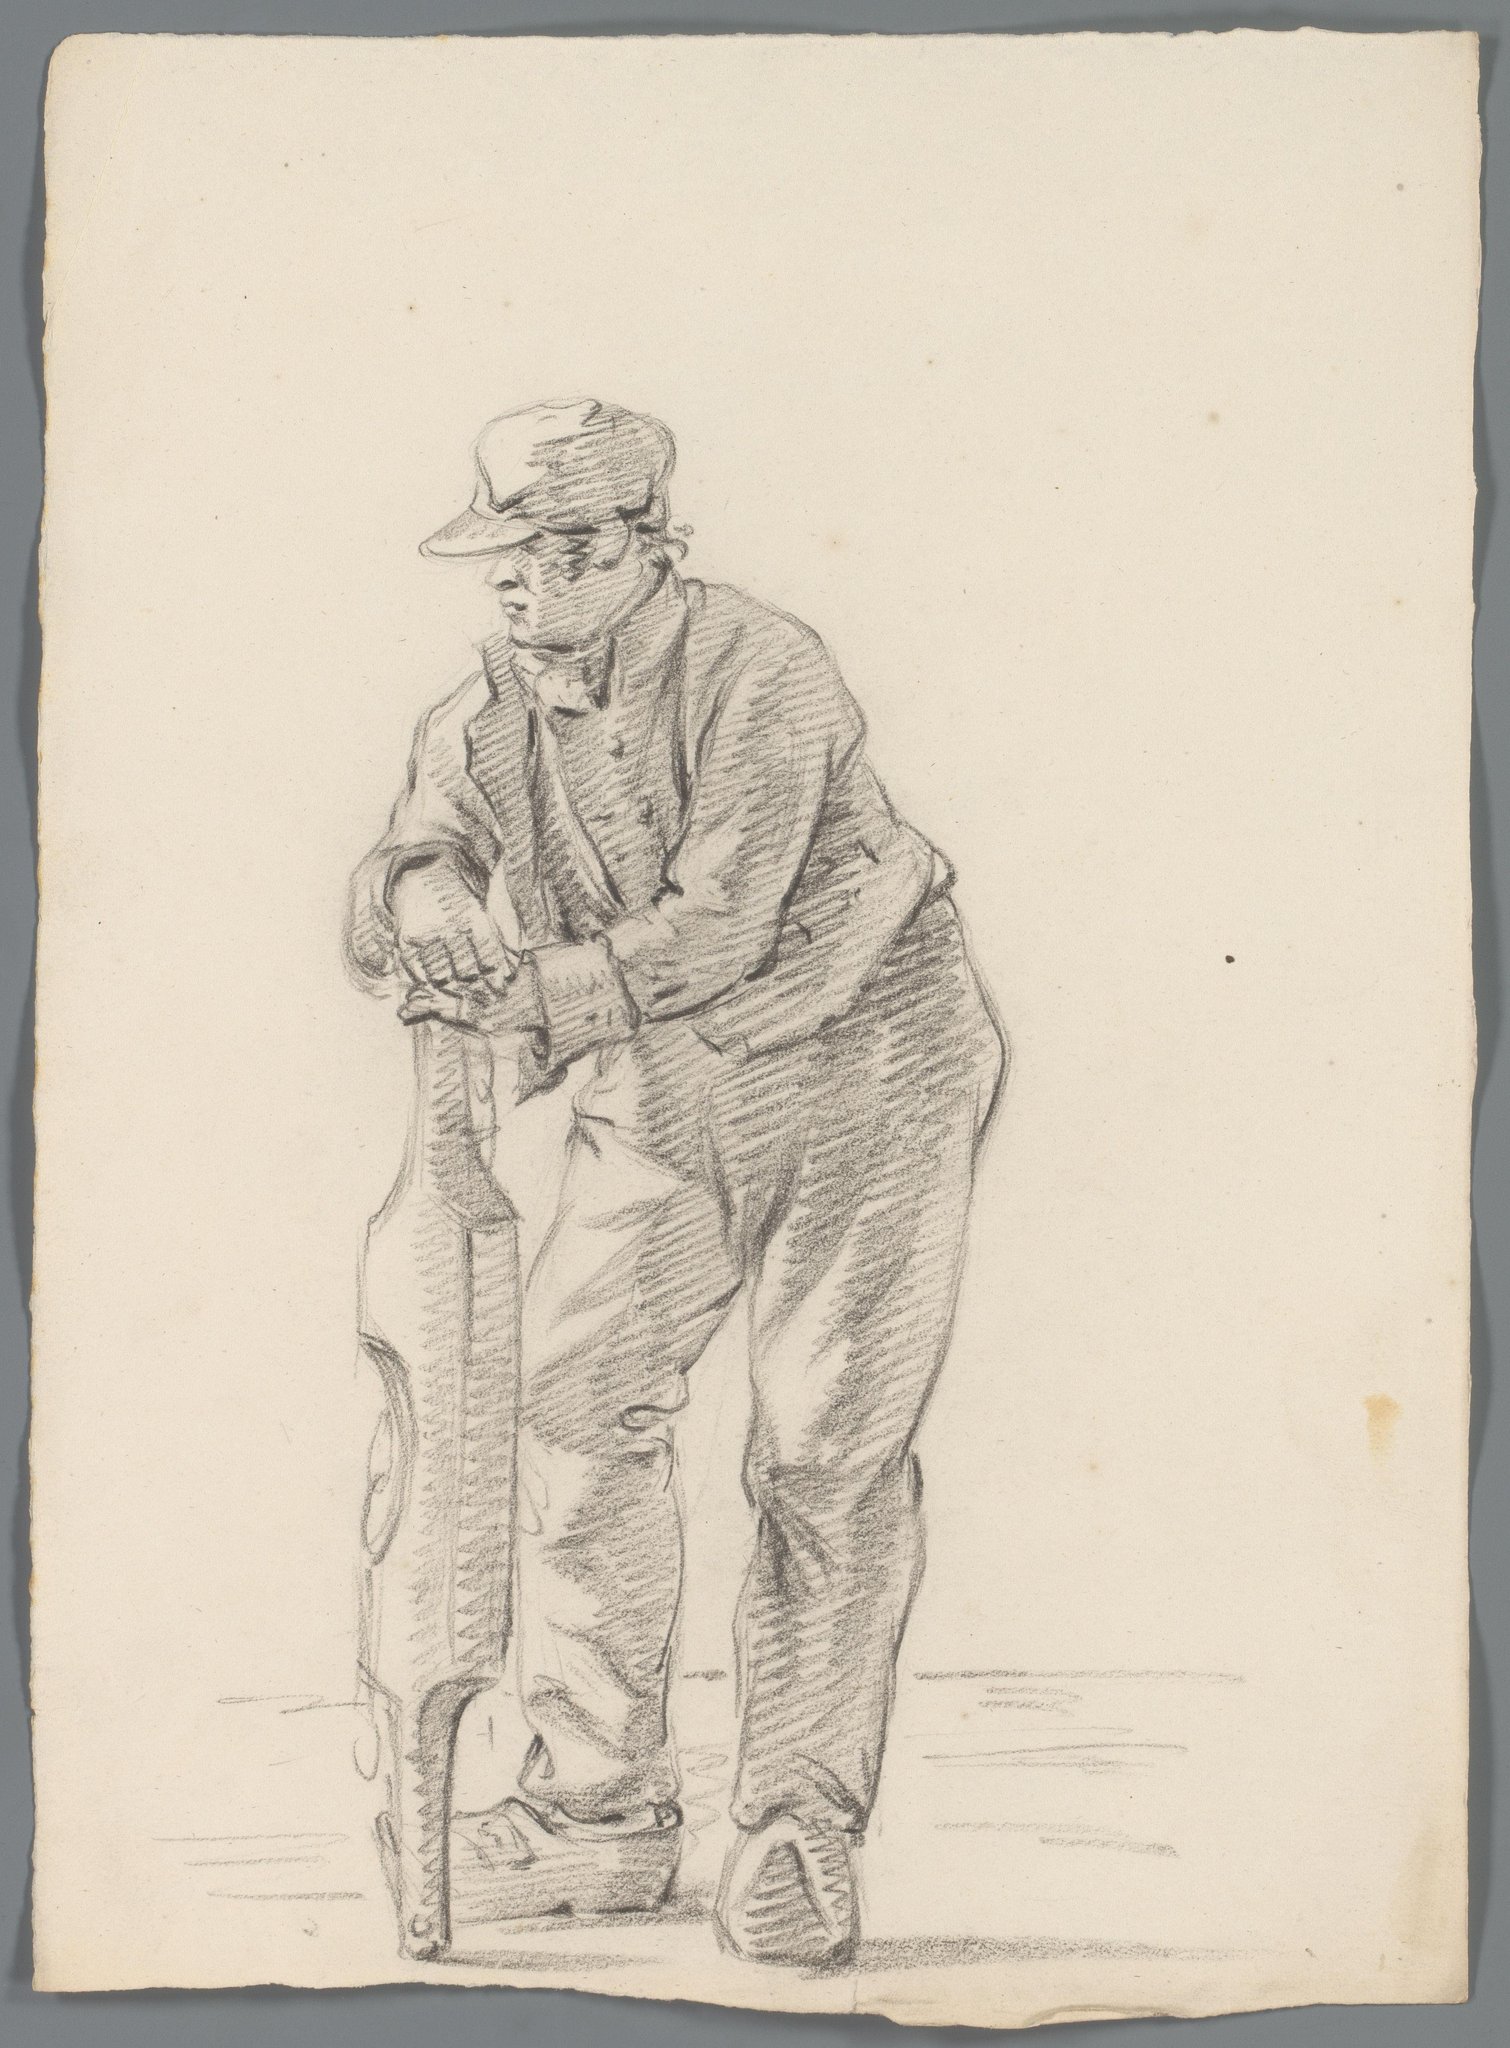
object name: drawing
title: Man leunend op een juk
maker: Anonymous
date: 1820-1830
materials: chalk, paper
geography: the hague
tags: wooden shoes, clogs, adult man, yoke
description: Tekeningen waarschijnlijk ontstaan bij het Haagse kunstgenootschap ‘Tot Nut der Tekenkunst’, waar twee keer per week tekenavonden werden georganiseerd met geklede modellen.